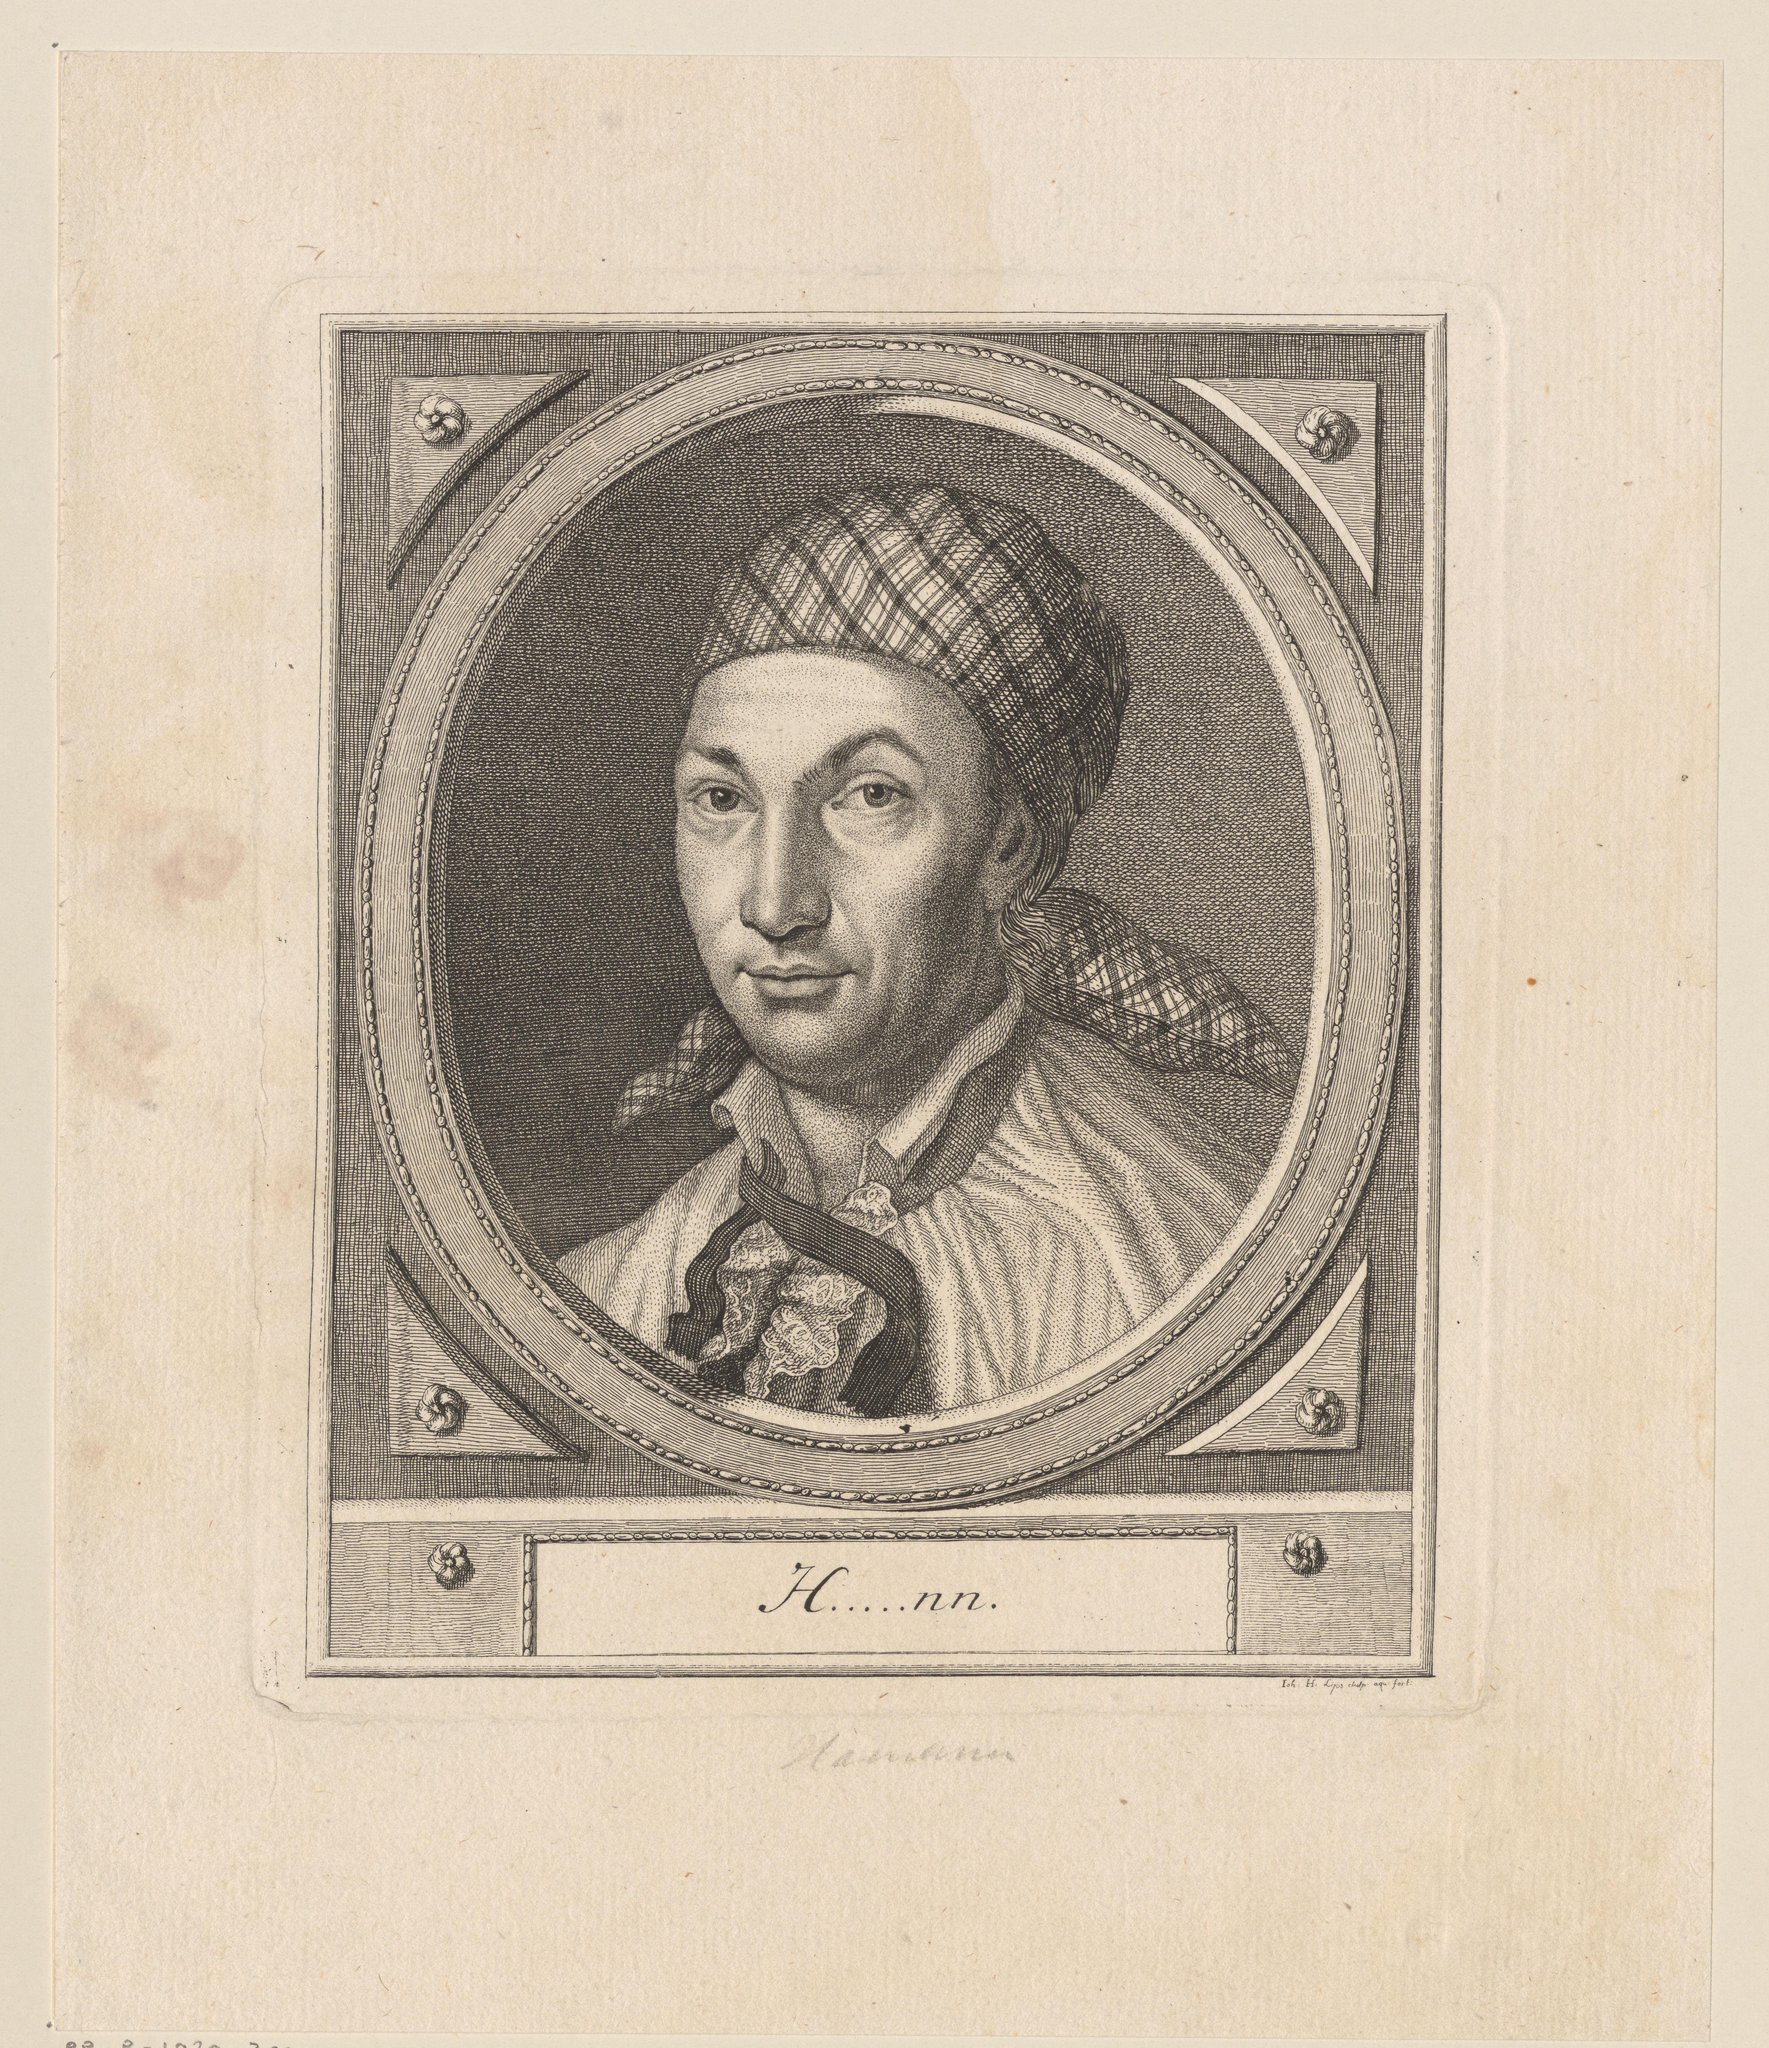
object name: print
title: Portret van Johann Georg Hamann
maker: johann heinrich lips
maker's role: draughtsman, painter, print maker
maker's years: 1758-1817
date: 1768-1817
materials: paper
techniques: engraving, etching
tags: scholar, philosopher, historical persons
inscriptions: collector's mark: Lugt 2228